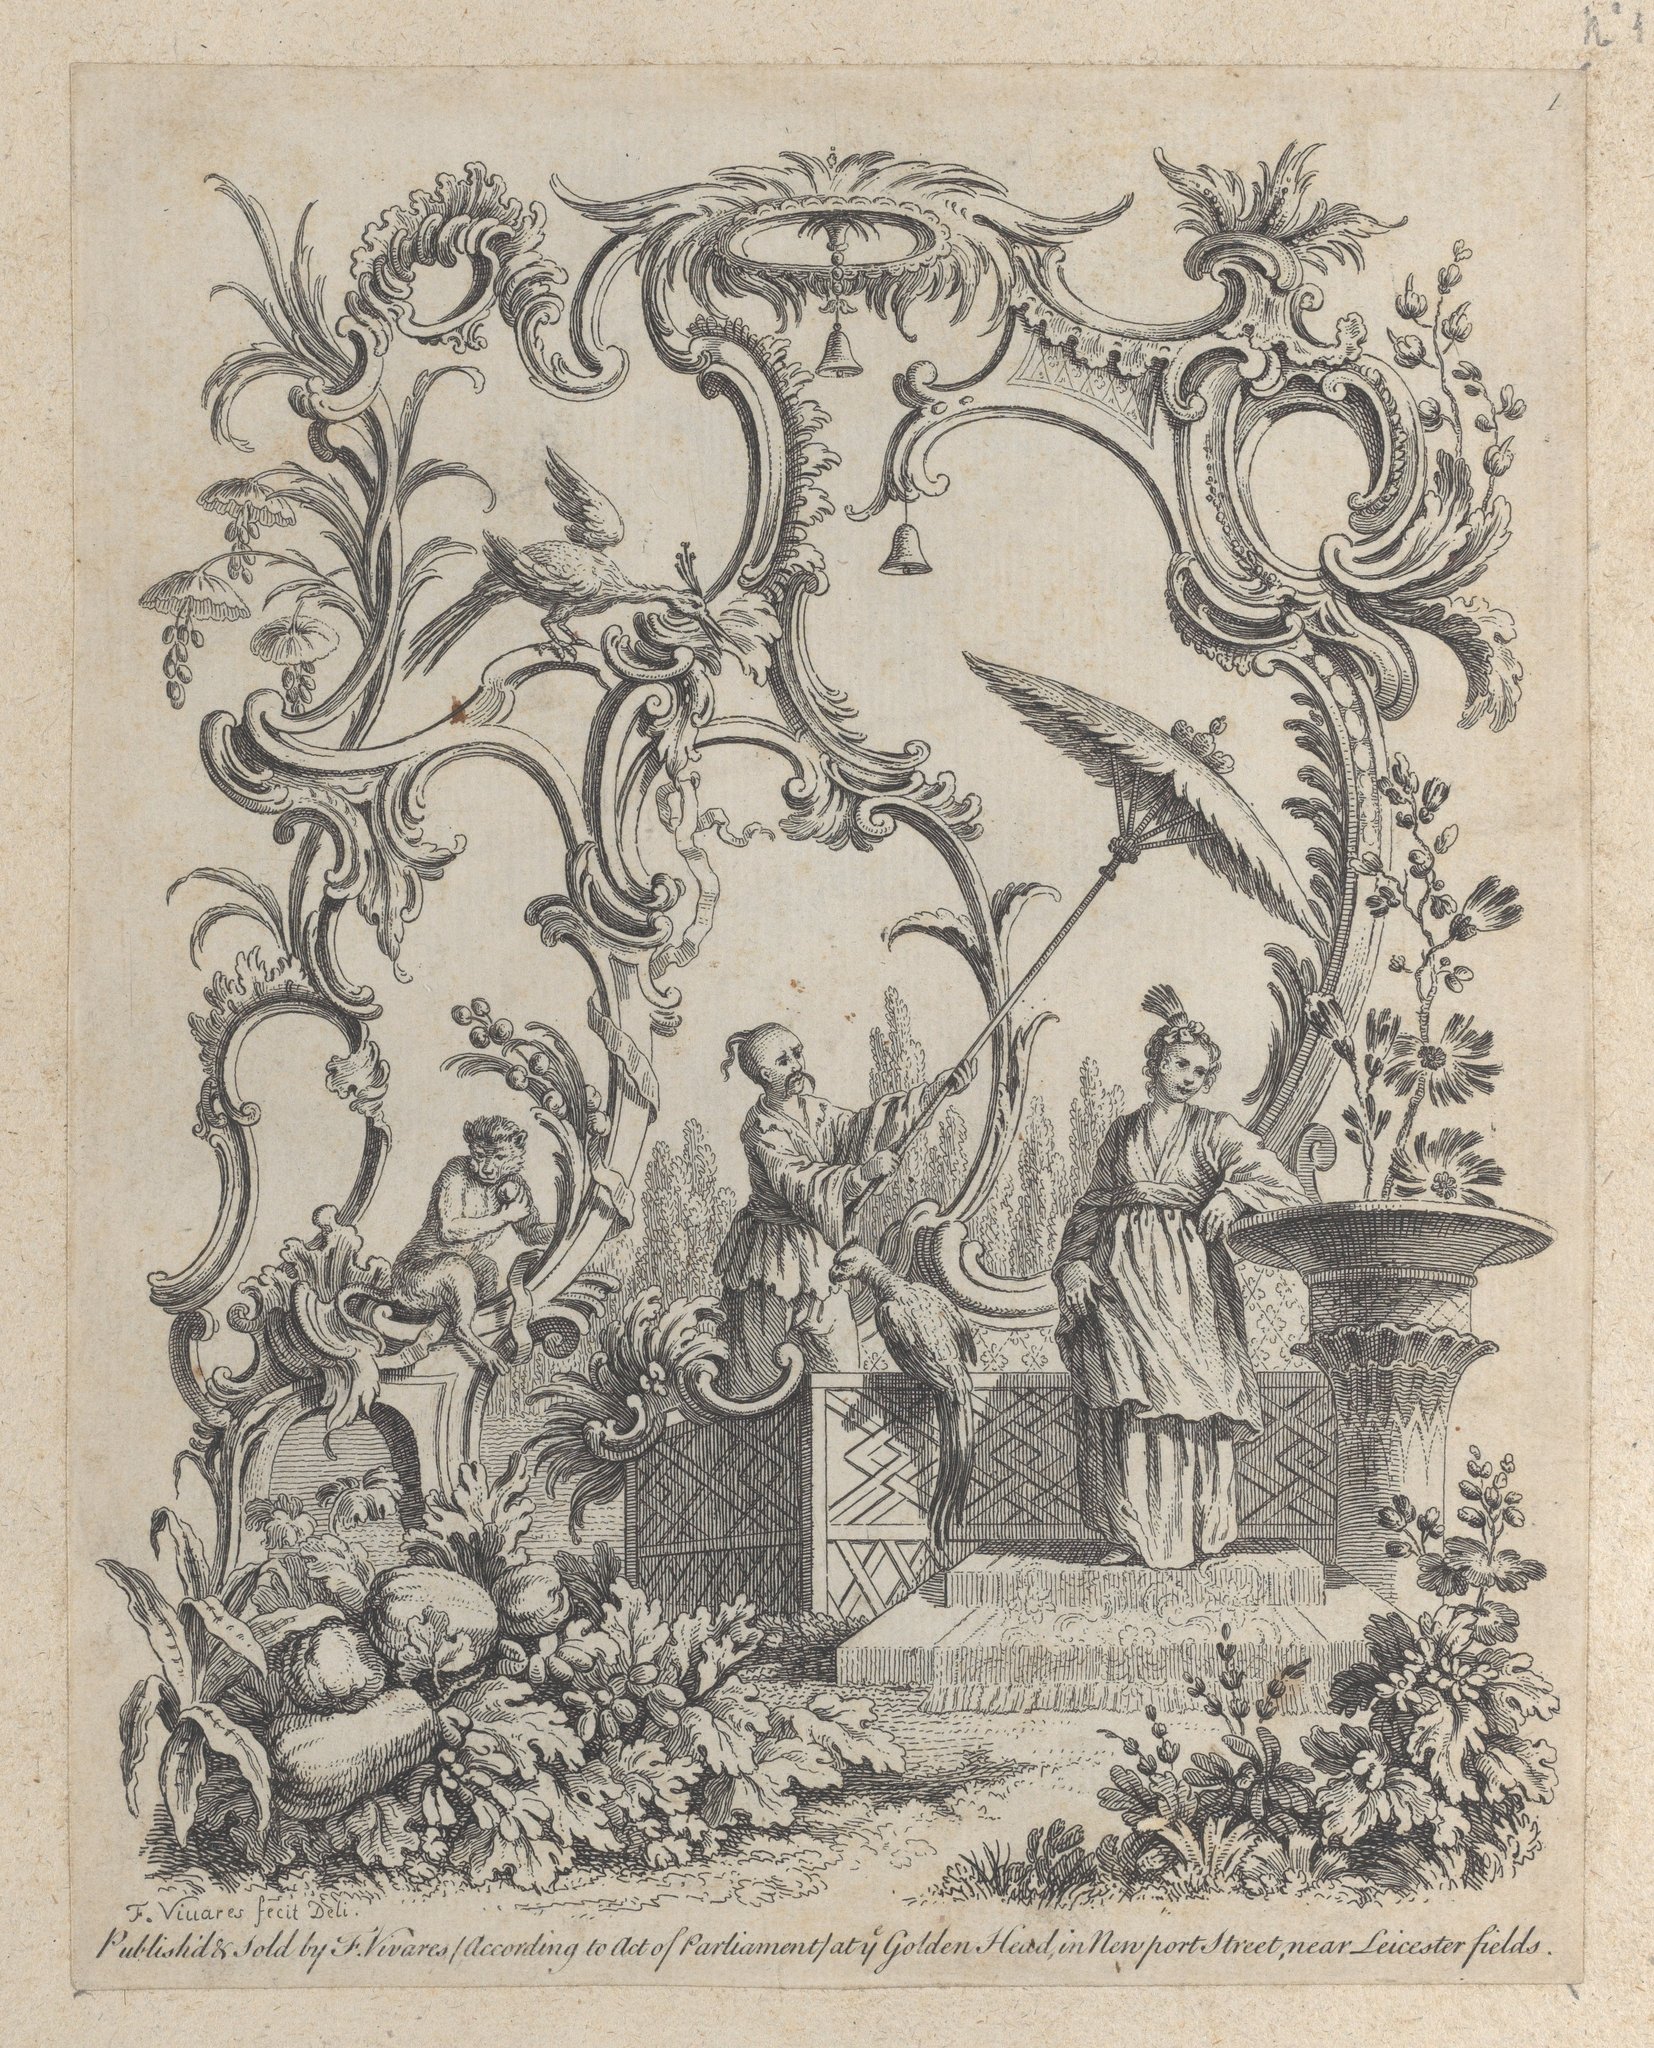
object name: book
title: Ornaments Chinois (Bound Collection of Chinoiserie Panels)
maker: françois vivares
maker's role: artist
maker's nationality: french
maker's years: 1709-1780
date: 1765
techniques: etching